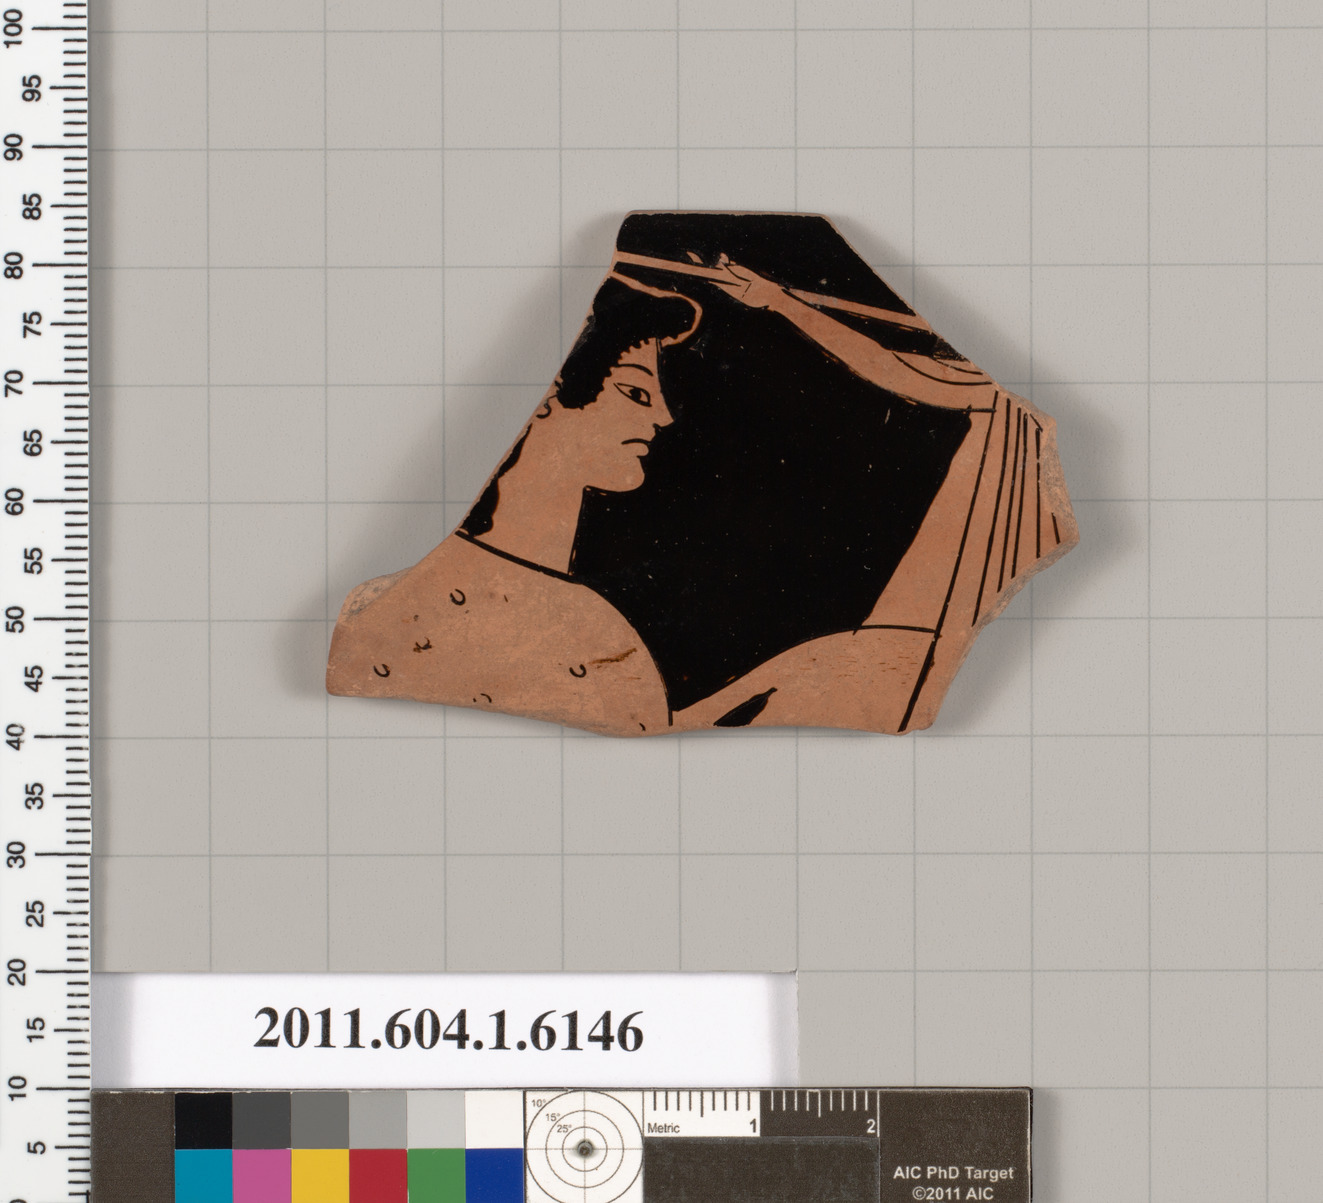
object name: kylix fragment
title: Terracotta rim fragment of a kylix (drinking cup)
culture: greek, attic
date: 520-500 BCE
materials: terracotta